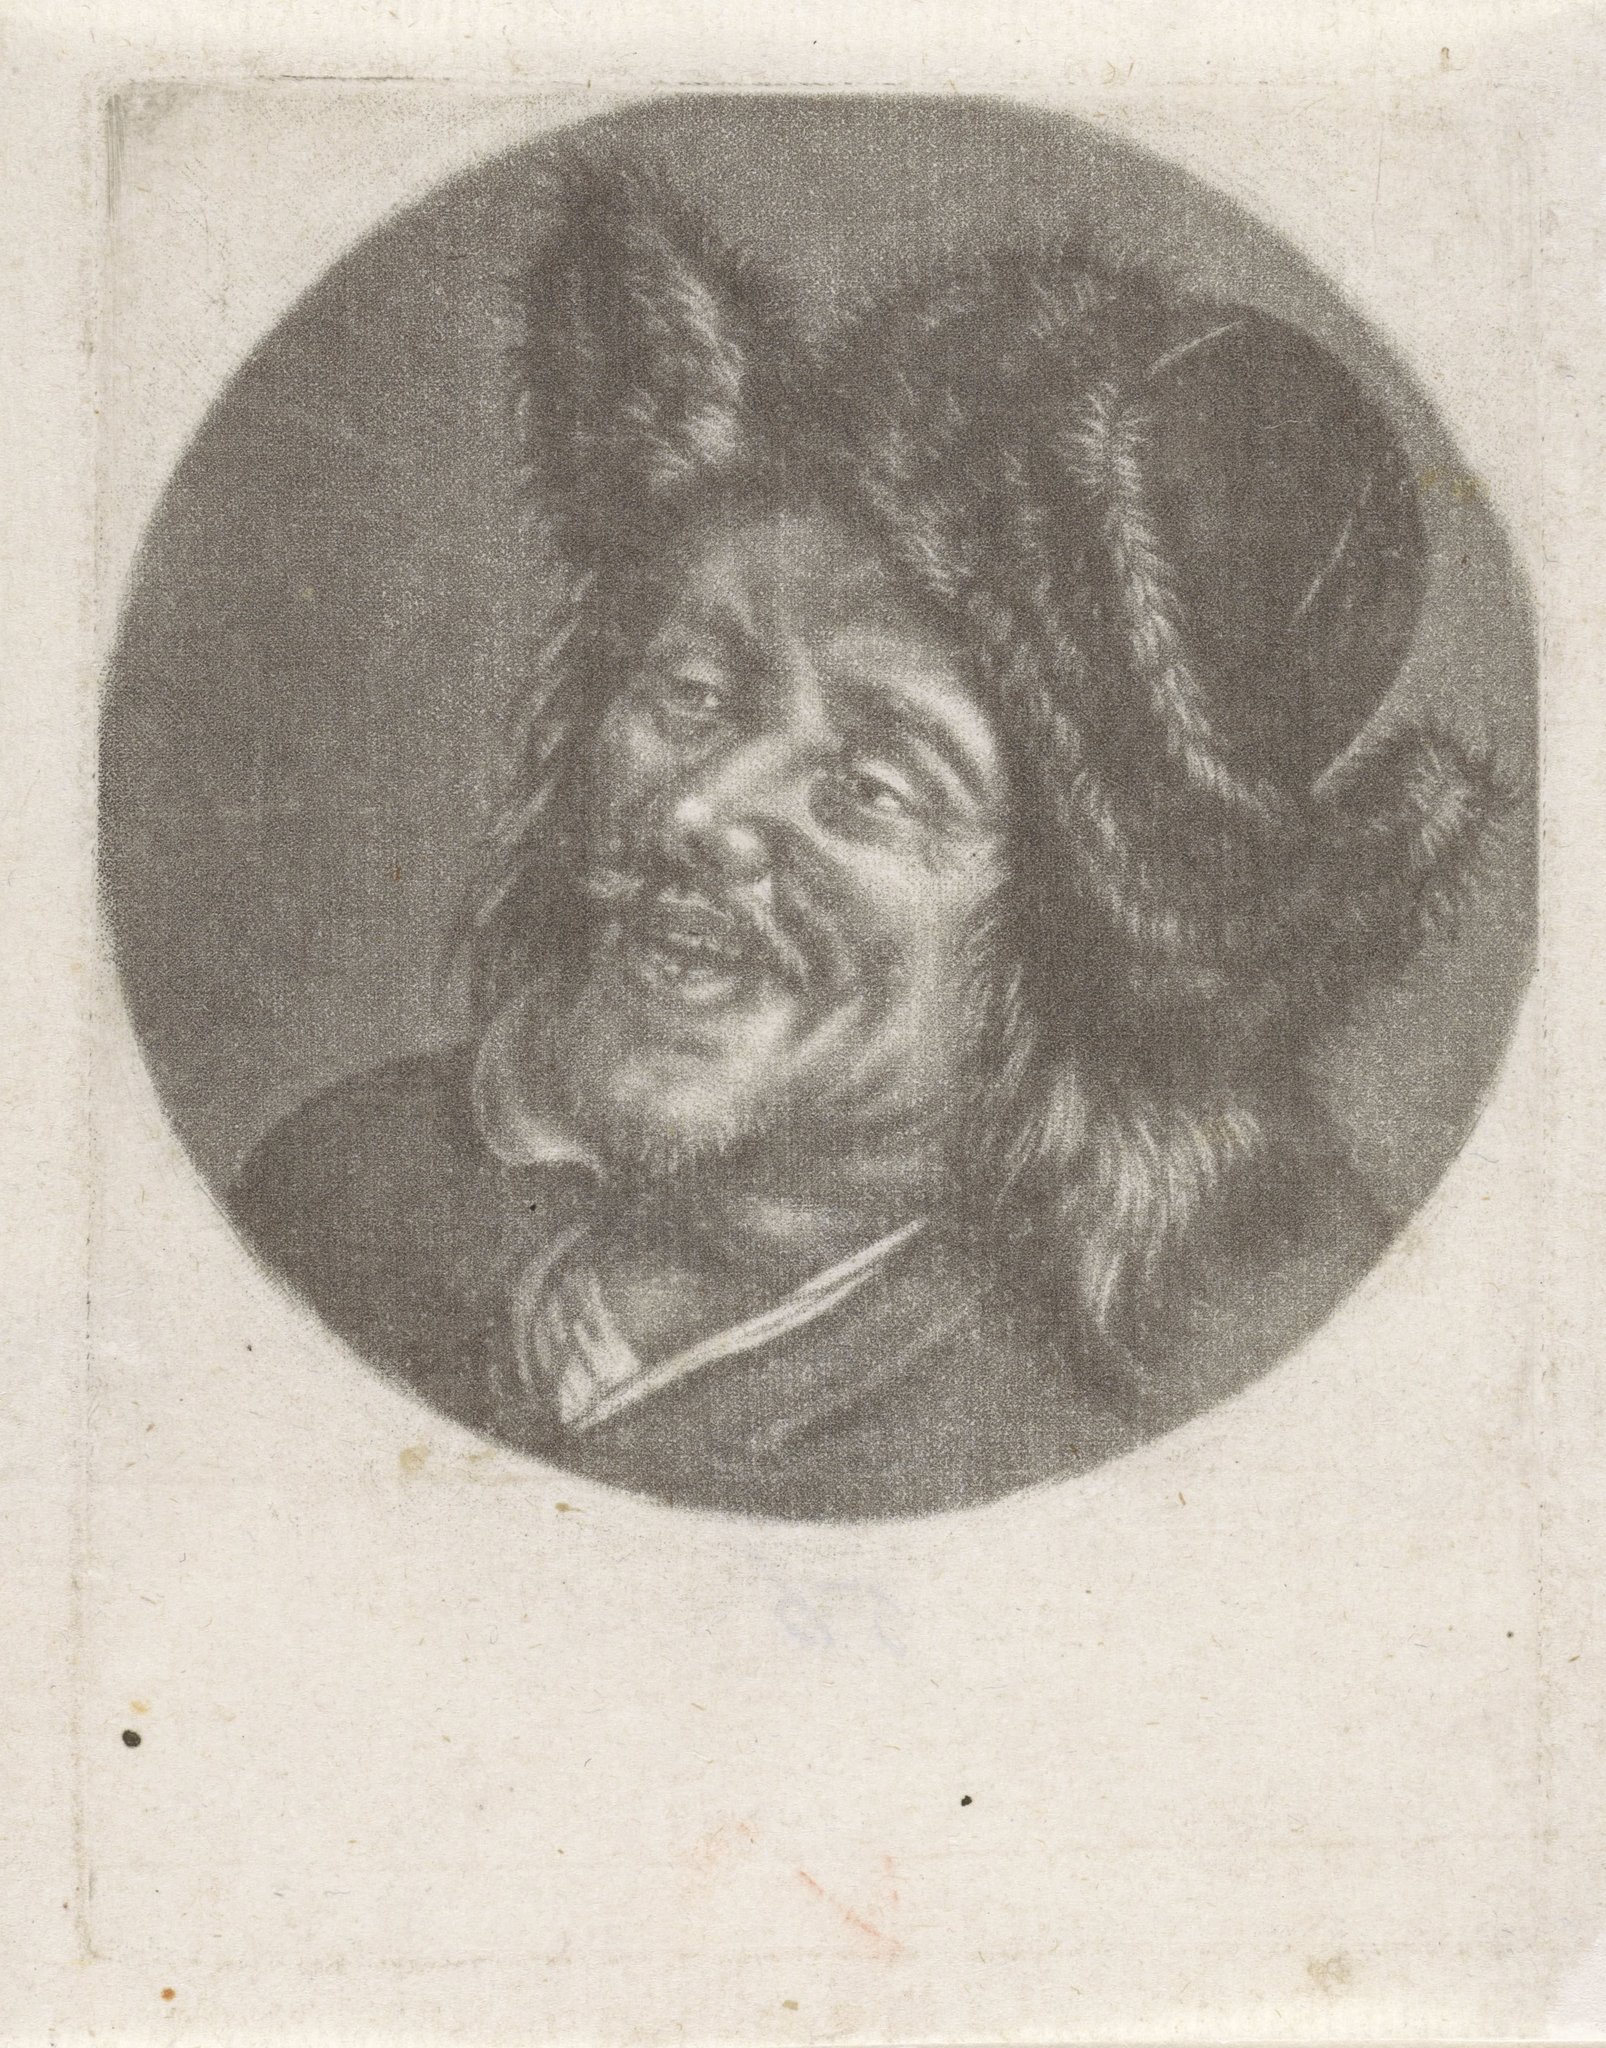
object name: print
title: Kop van een lachende man met een bontmuts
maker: Anonymous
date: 1650-1800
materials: paper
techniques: mezzotint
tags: head-gear, laughing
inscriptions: collector's mark: Lugt 2228